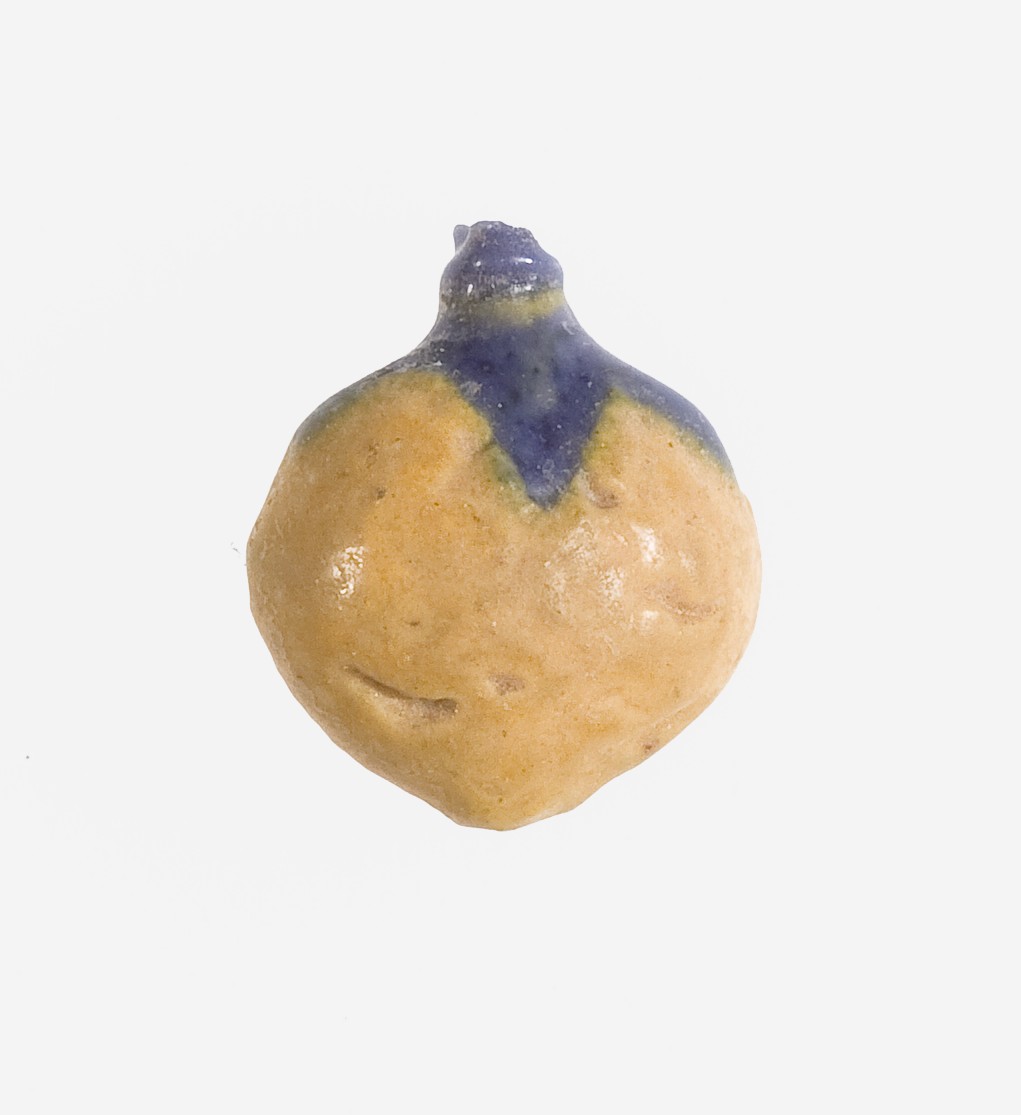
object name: pendant, persea fruit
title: Persea fruit pendant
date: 1390-1352 BCE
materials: faience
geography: egypt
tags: fruit